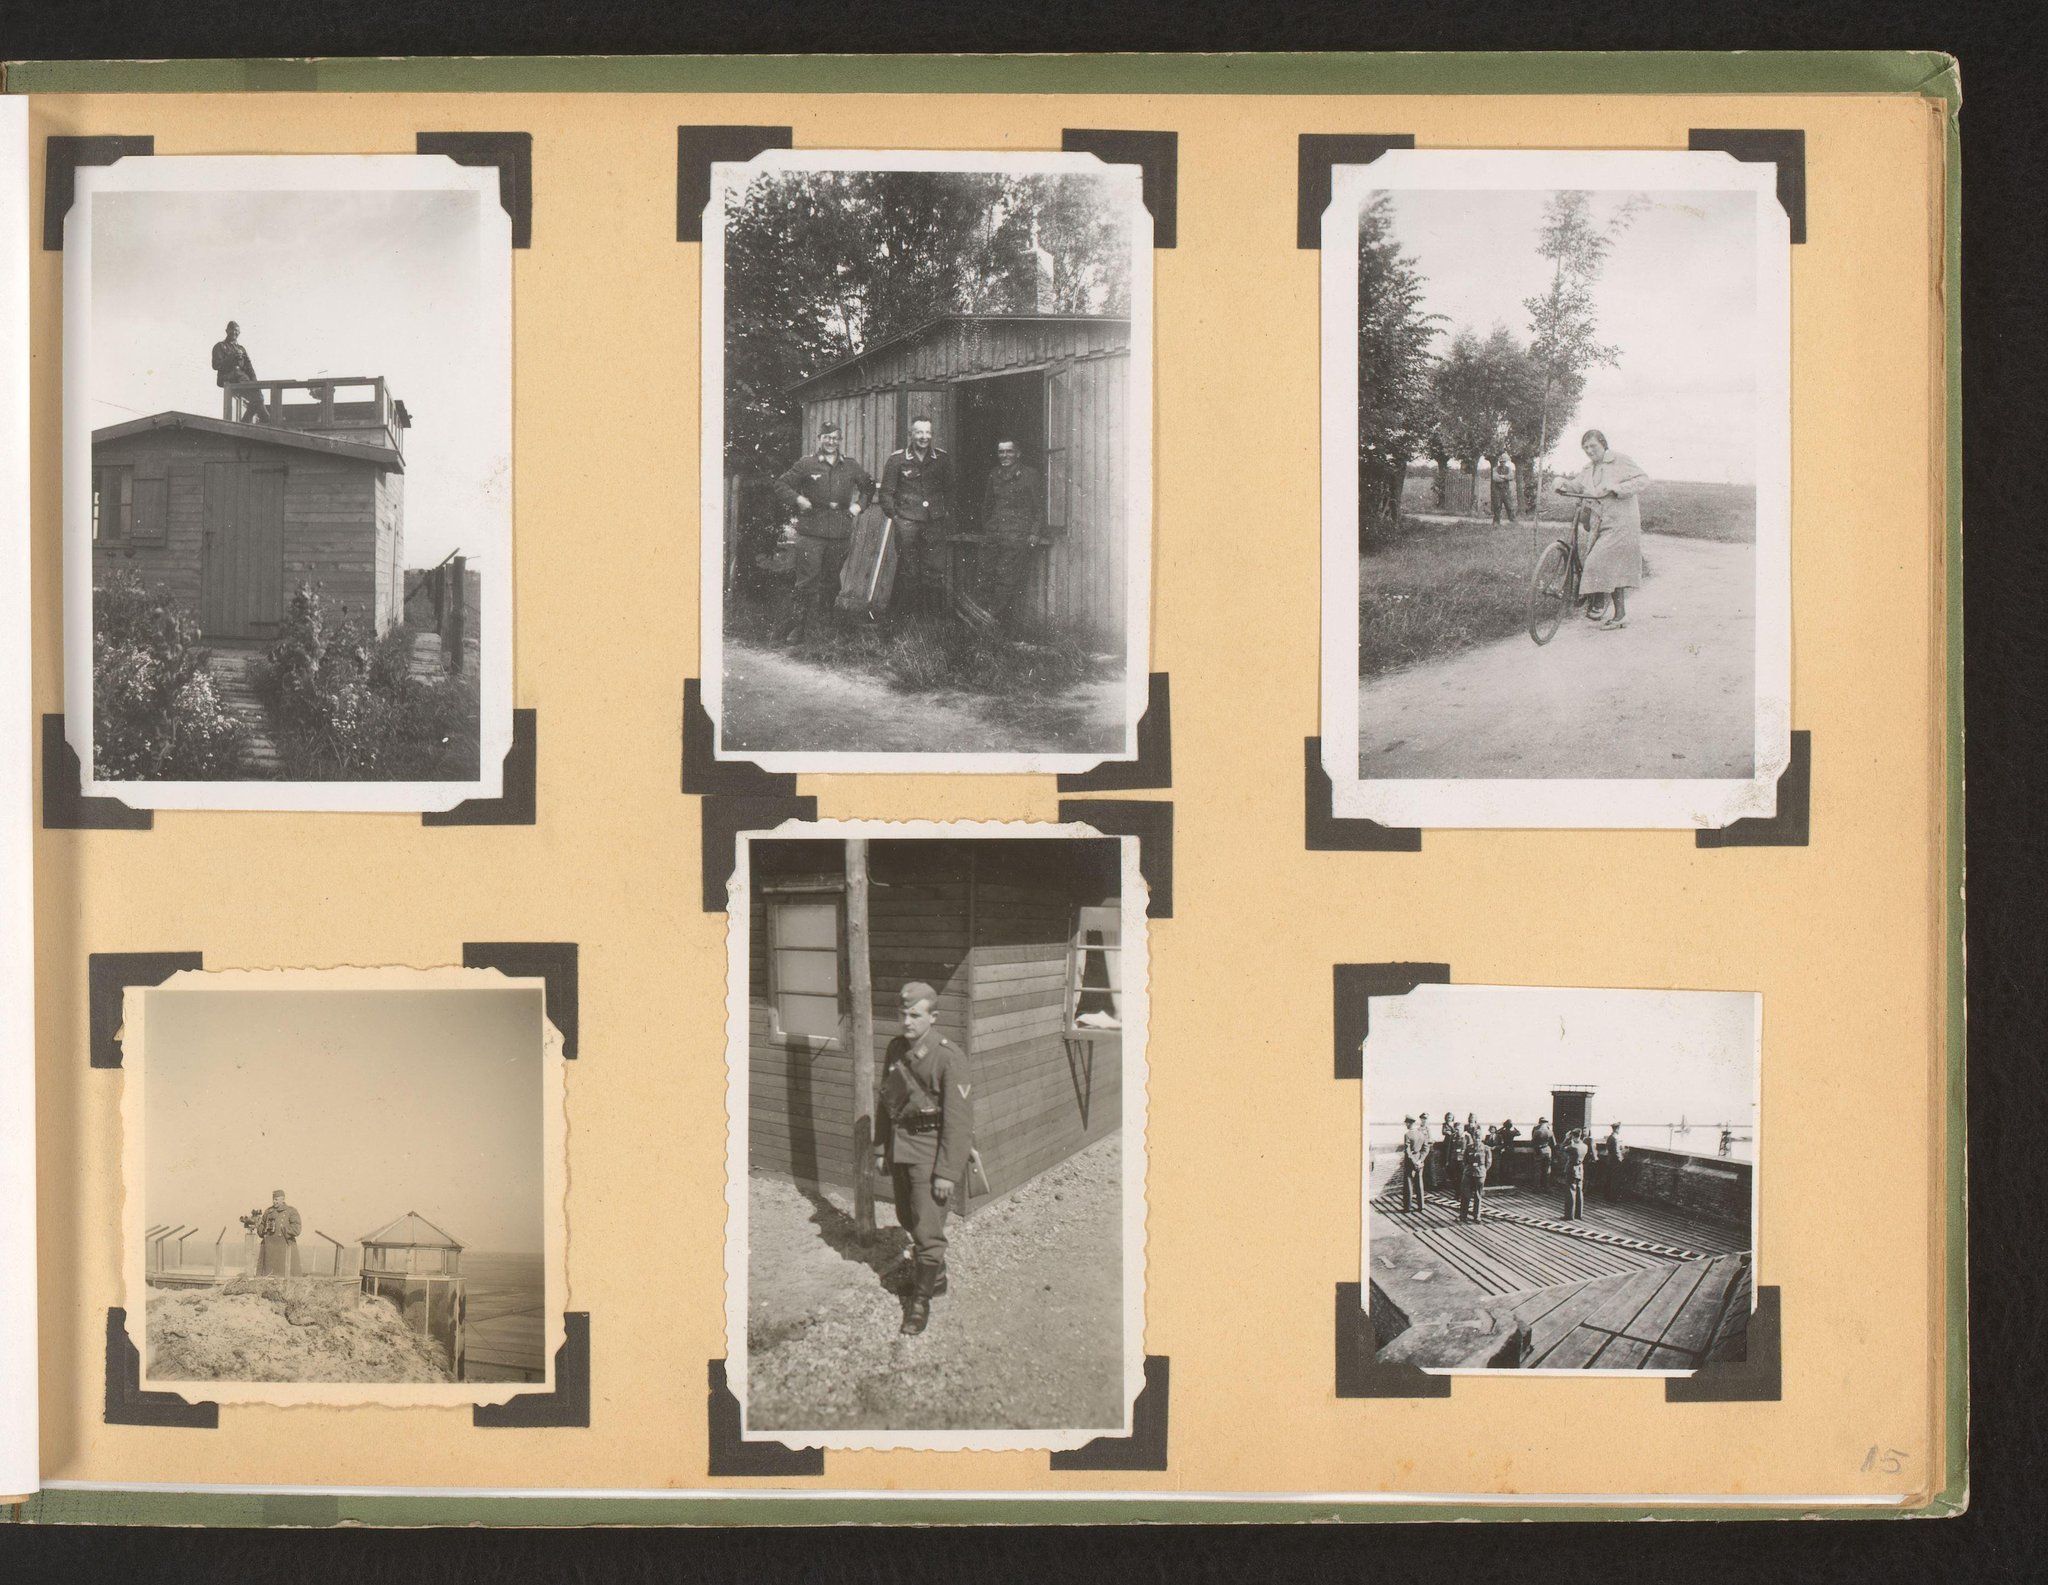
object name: photograph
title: Behuizing en bunker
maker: Anonymous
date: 1940-1944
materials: paper, photographic support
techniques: gelatin silver print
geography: netherlands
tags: the company, the unit, the troop ~ military service, permanent fortifications, shelter ~ military service, netherlands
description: Albumblad met zes foto´s van Duitse militairen in hun behuizing en bij een bunker aan de Noordzeekust. Onderdeel van het fotoalbum Bewaking bunkers.